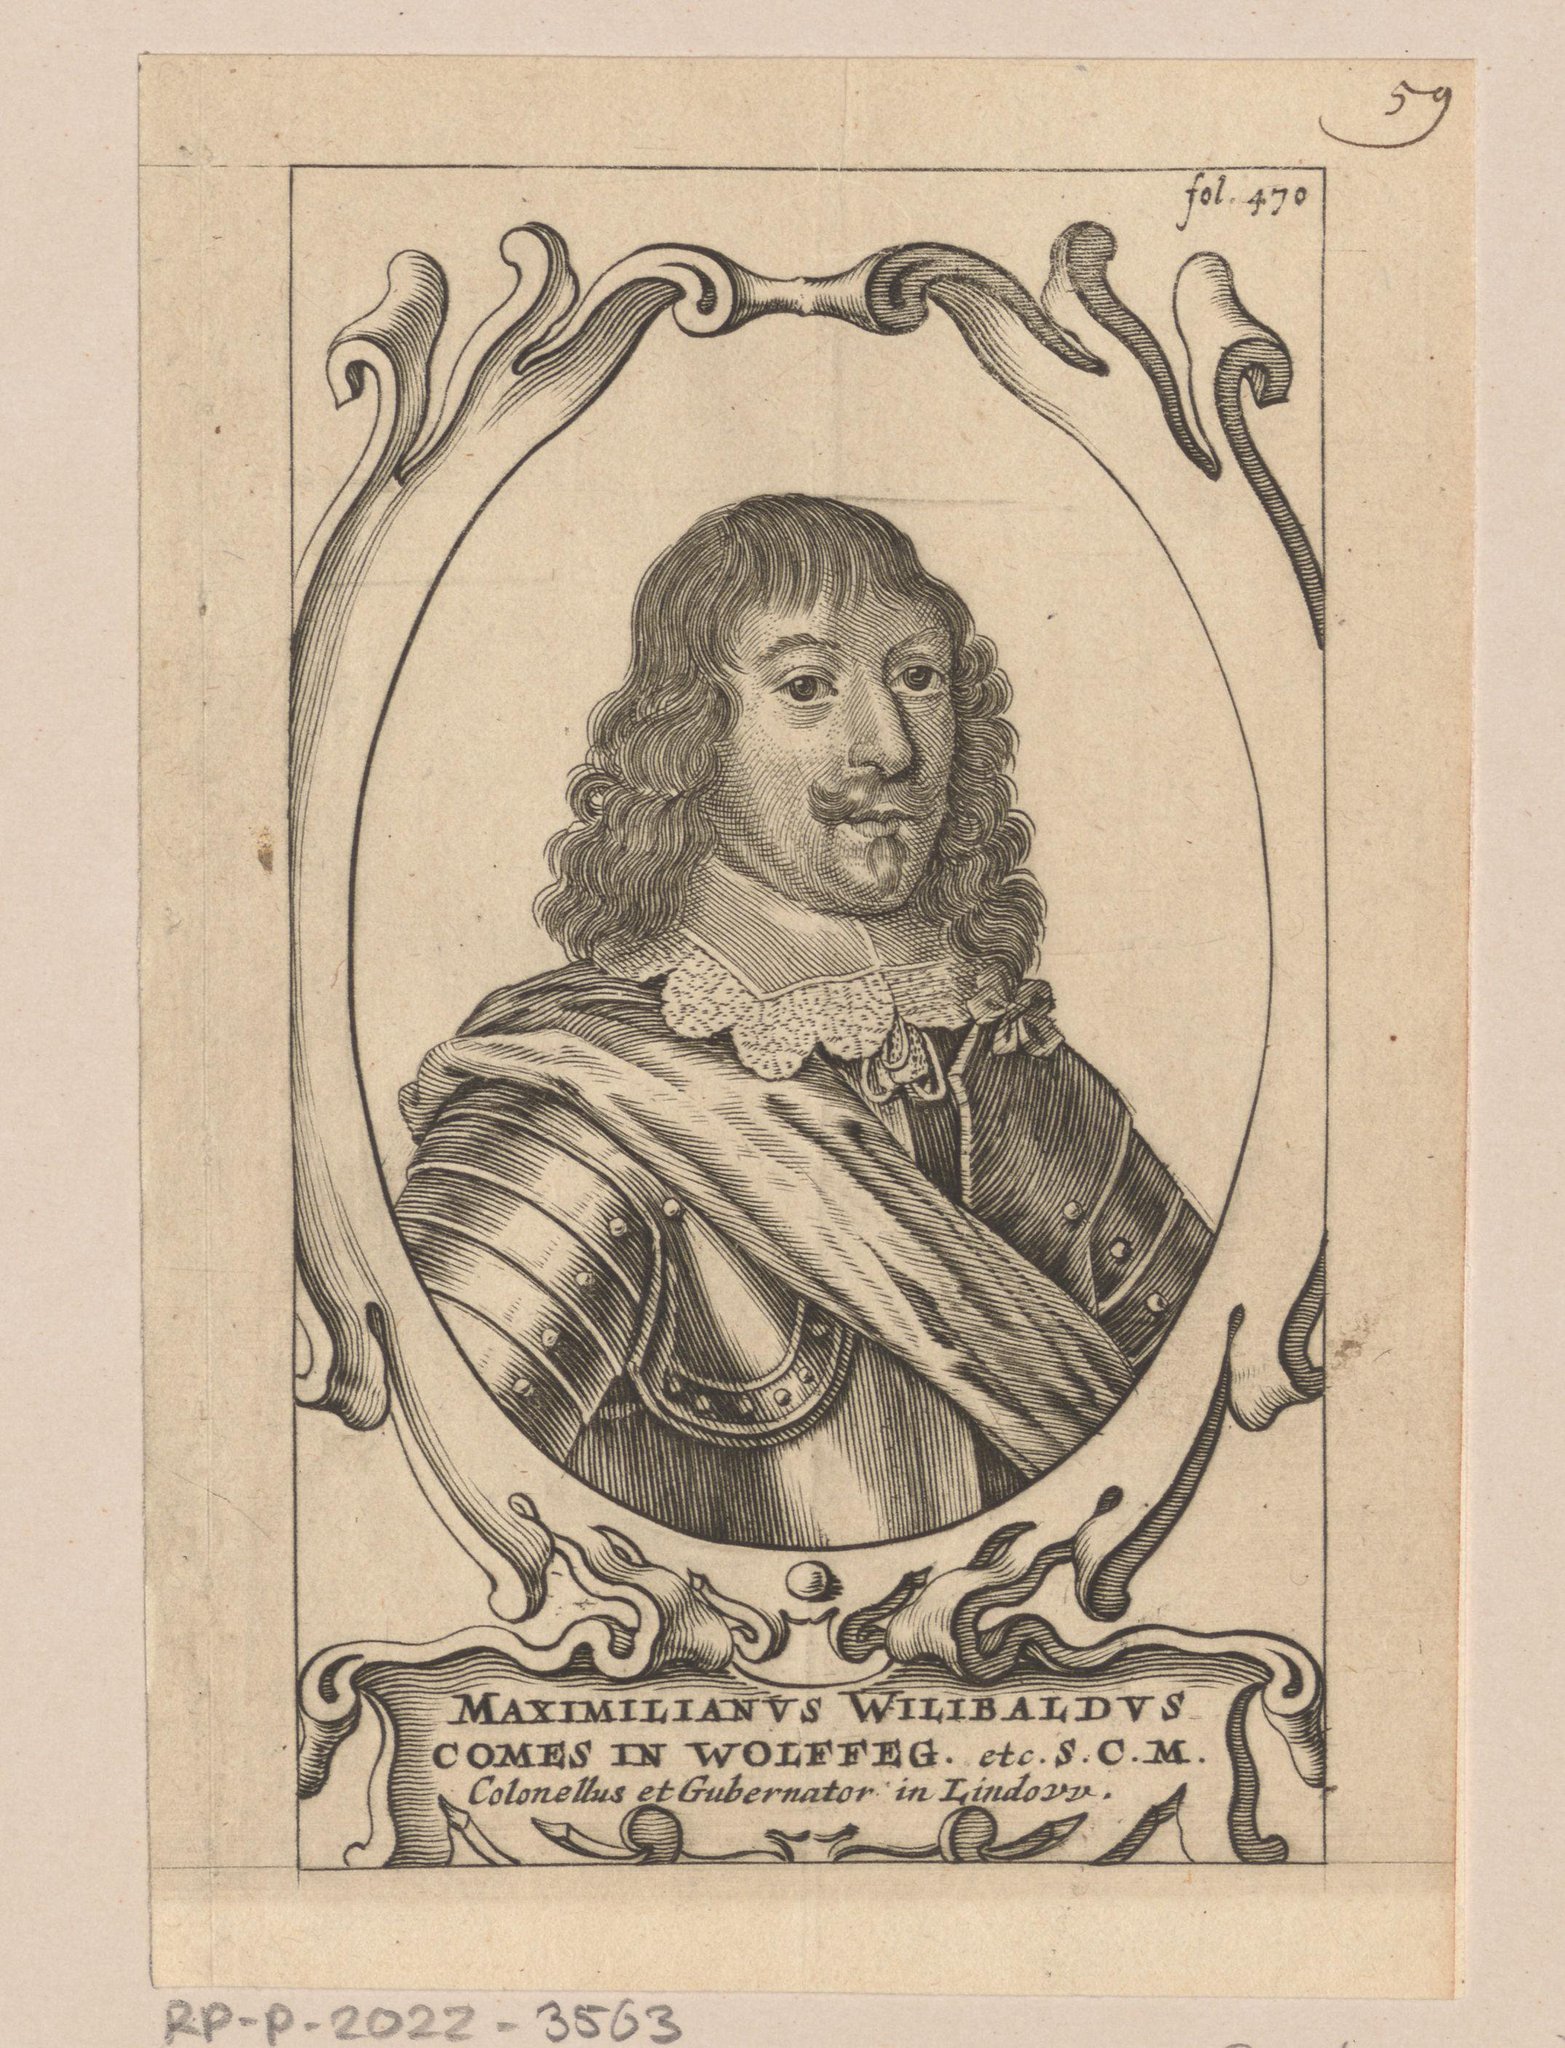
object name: print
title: Portret van Maximilian von Waldburg-Wolfegg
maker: Anonymous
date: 1656-1666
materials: paper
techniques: engraving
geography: northern netherlands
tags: amberg, earl, maximilian willibald von waldburg-wolfegg (graaf), commander-in-chief, general, marshal, historical persons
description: Prent waarschijnlijk uit: Brachelius, Johannes Adolphus. Historia nostri temporis, dat is geschiedenis onses tijts (…). Rotterdam: Andries van Hoogenhuysen, 1656. Prent ook gebruikt in de 1659- en 1666 editie.